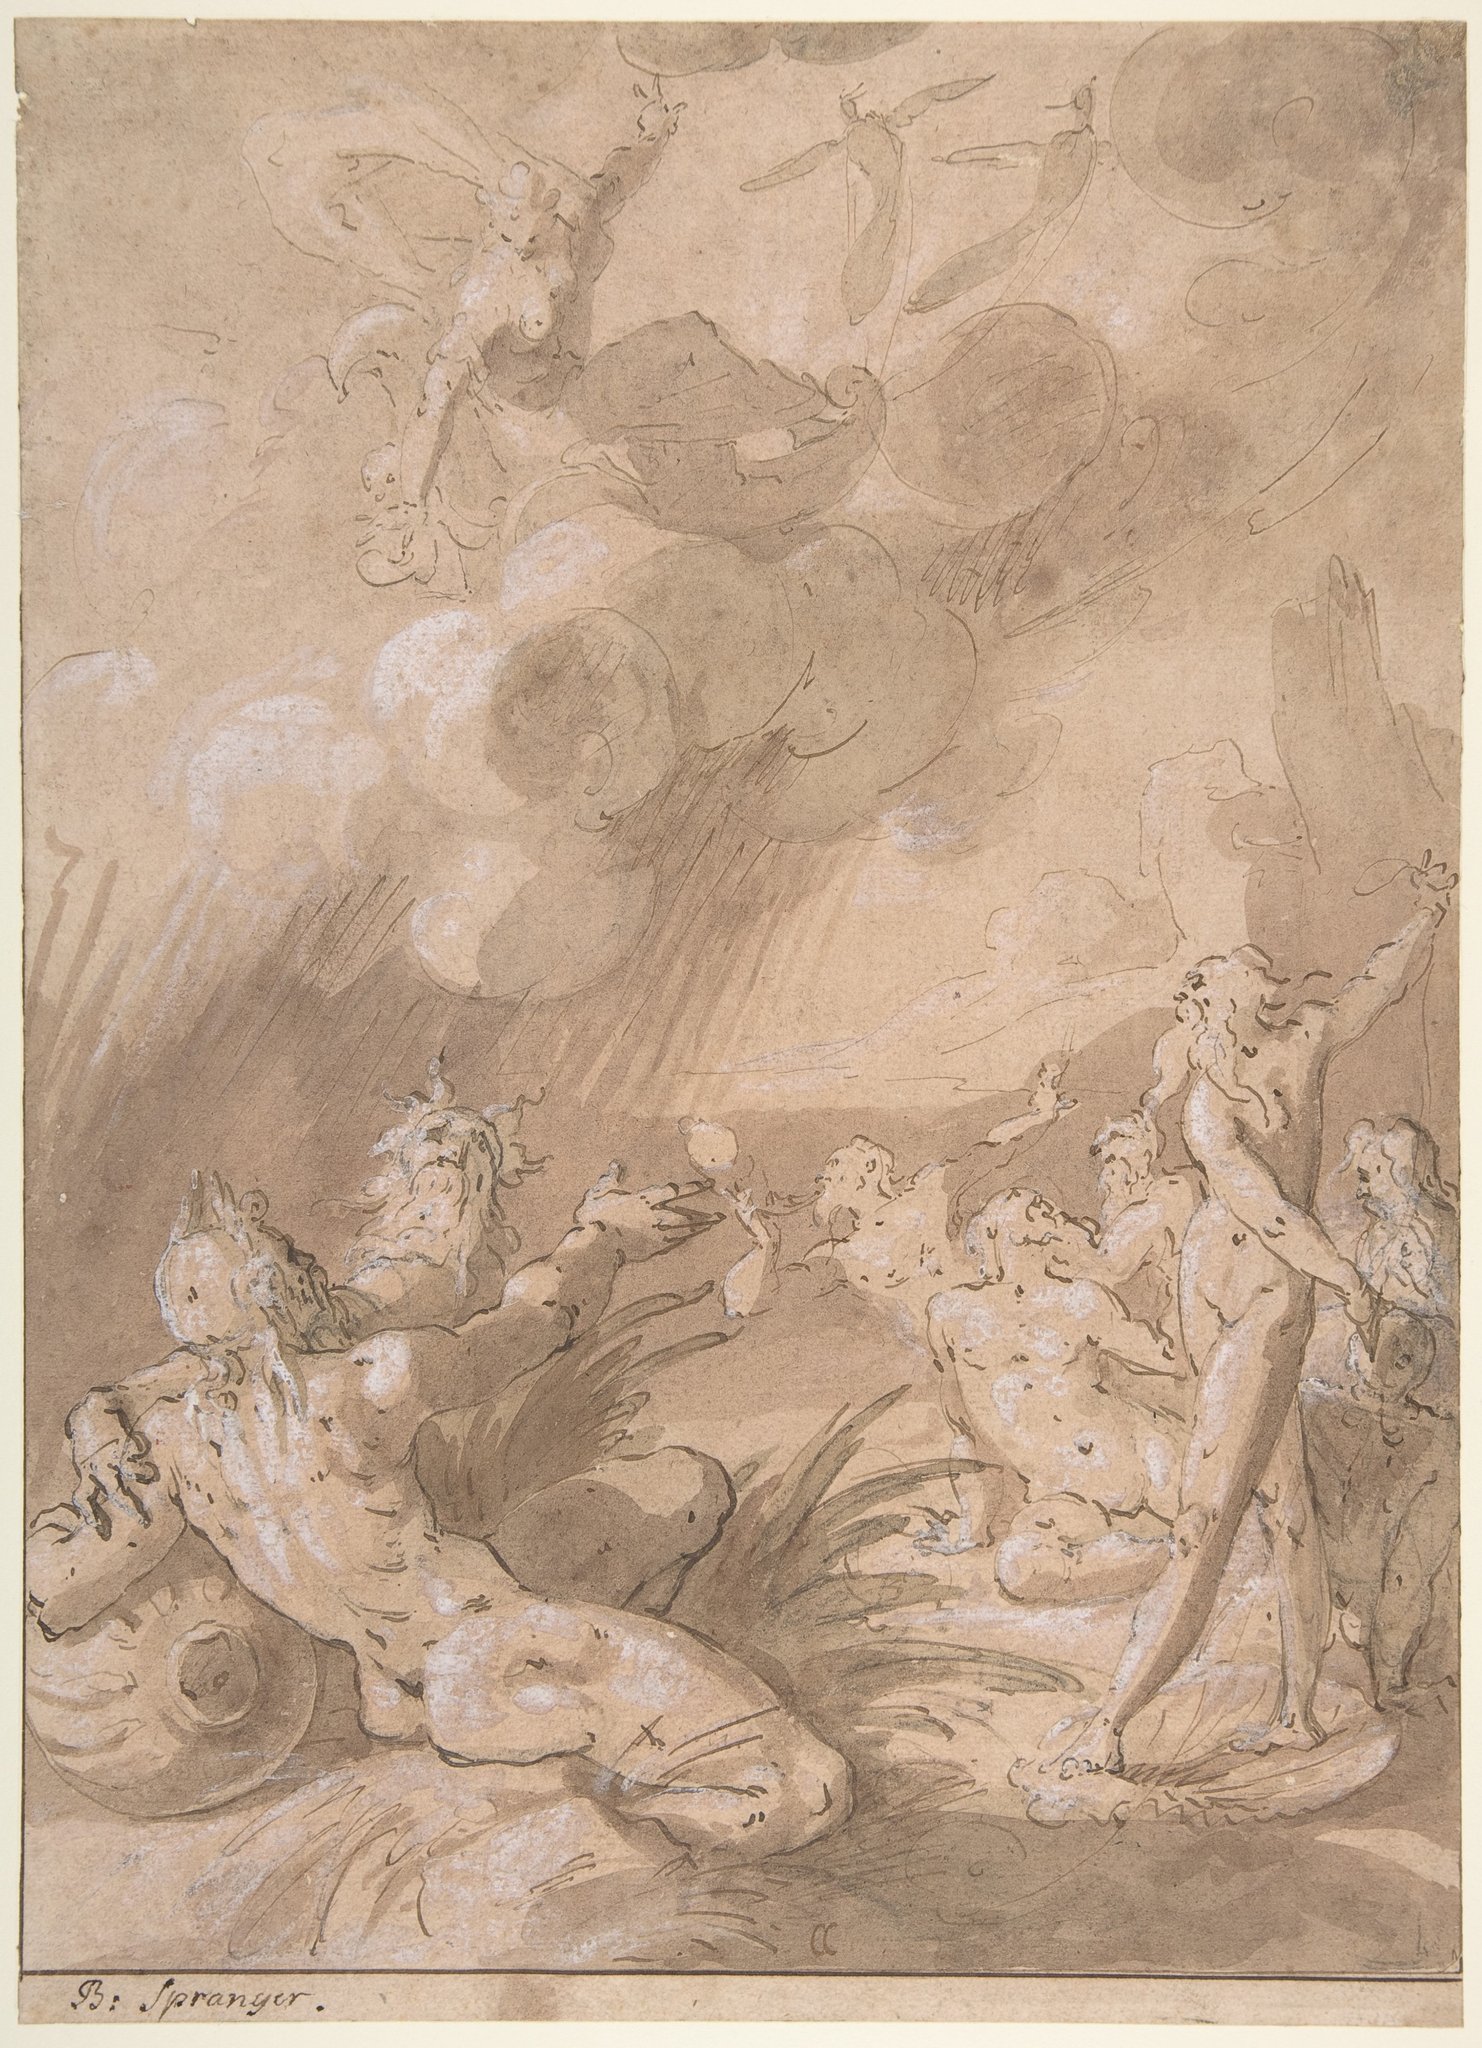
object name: drawing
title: Juno Appearing to Sea Gods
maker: cornelis cornelisz van haarlem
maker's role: artist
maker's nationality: netherlandish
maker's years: 1562-1638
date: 1567-1633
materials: chalk, gouache, ink, paper, watercolor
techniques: brush, heightening, pen, wash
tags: juno